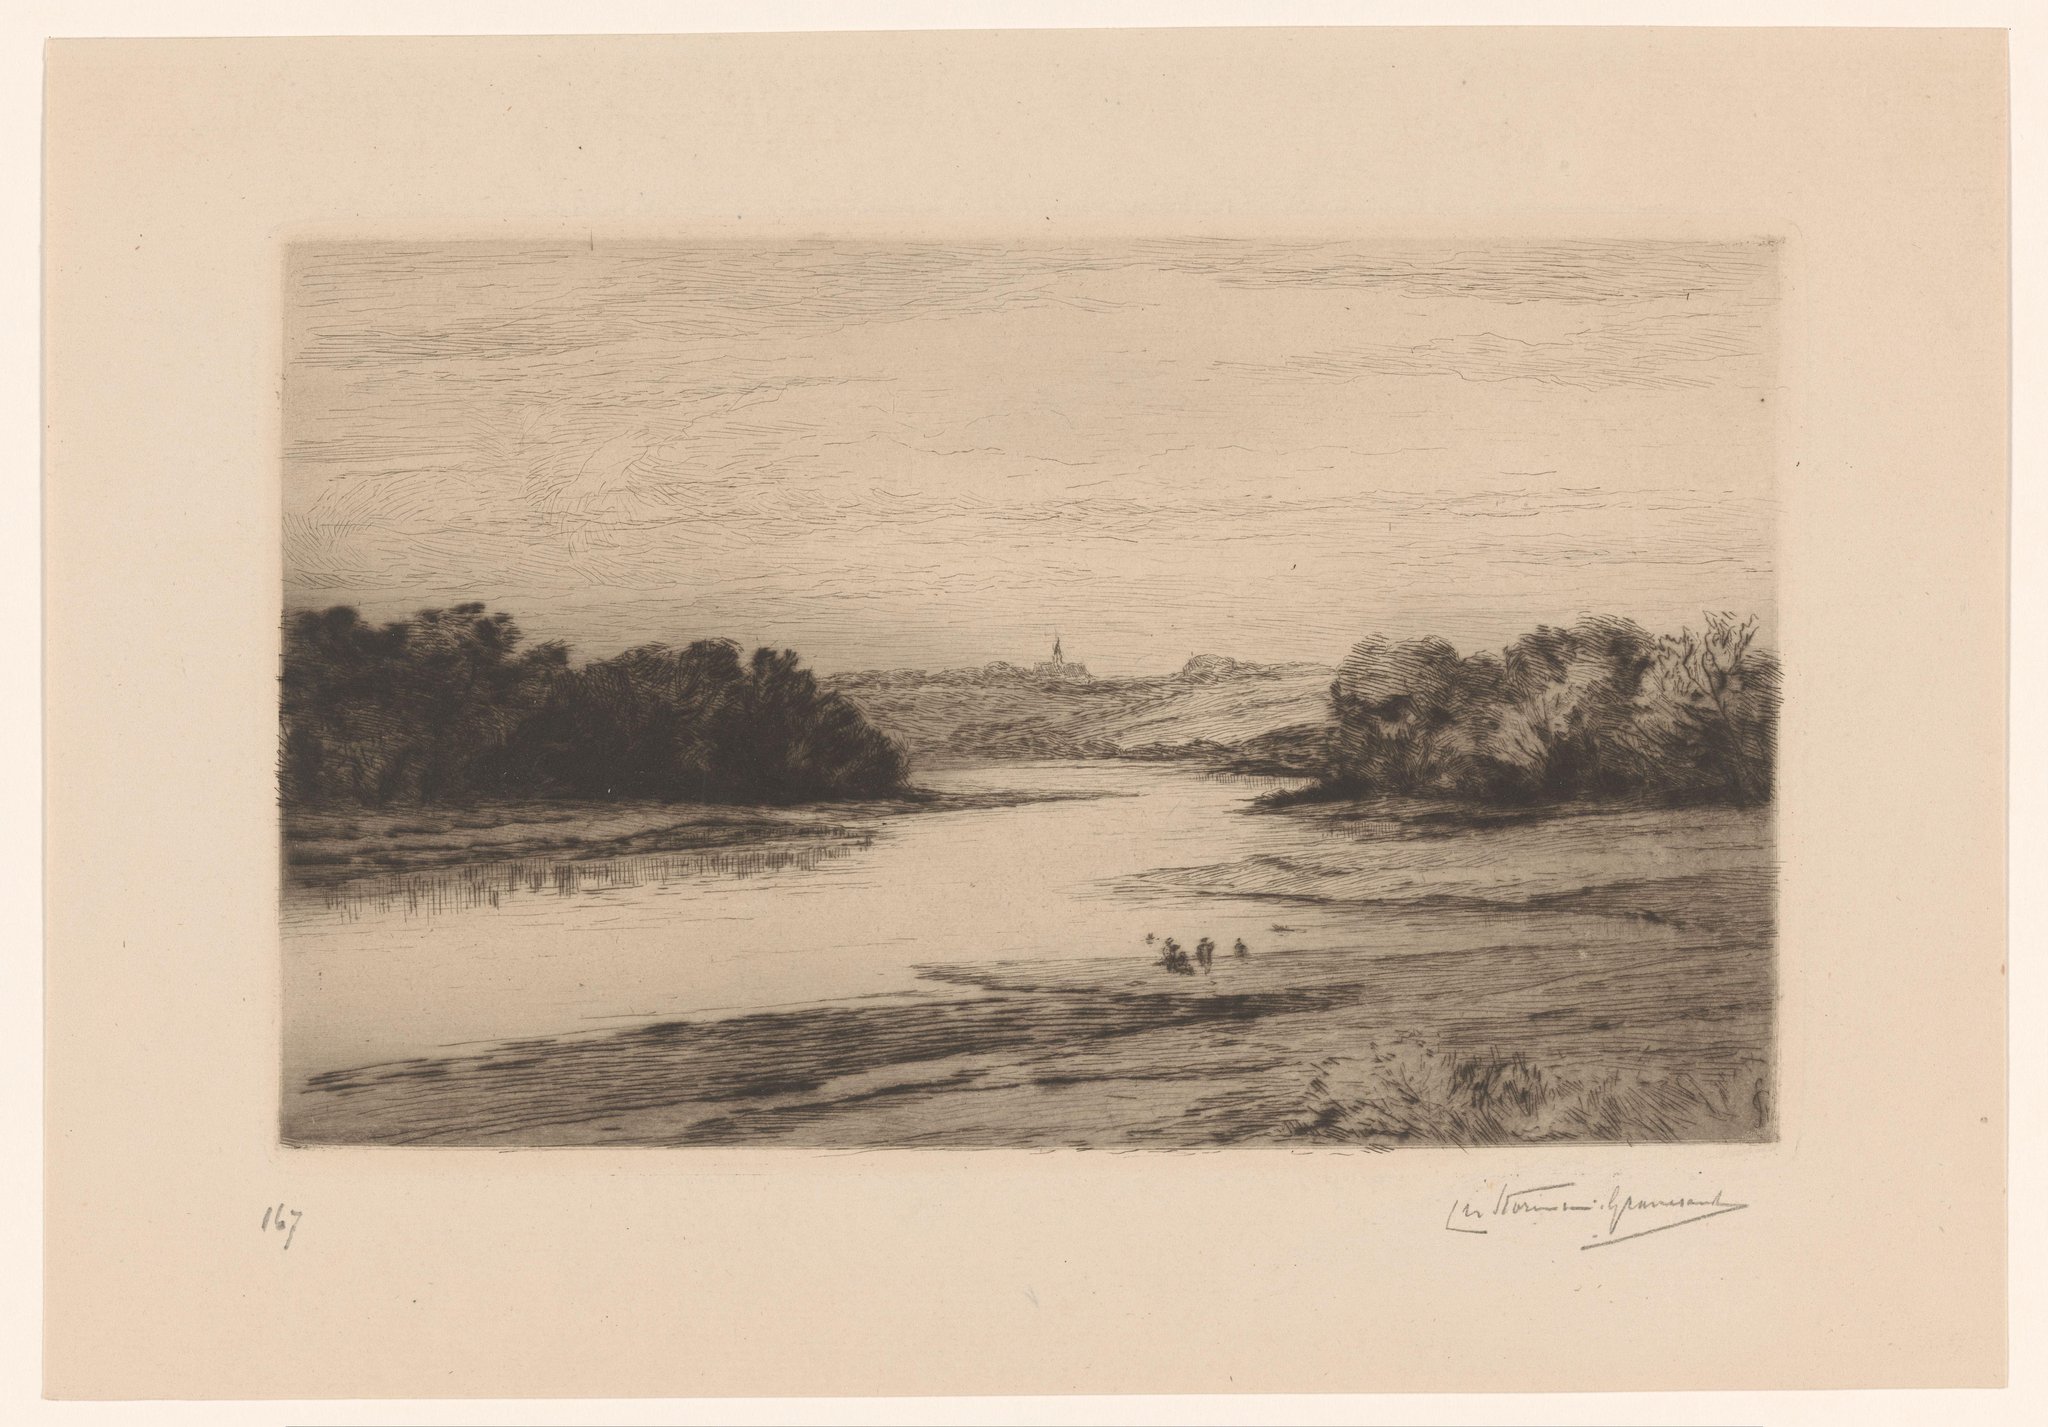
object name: print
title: Riviergezicht bij Auray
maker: carel nicolaas storm van s-gravesande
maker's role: draughtsman, print maker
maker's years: 1841-1924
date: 1880-1884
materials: paper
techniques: drypoint, intaglio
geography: netherlands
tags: river (+ landscape with figures, staffage)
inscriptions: collector's mark: Lugt 2228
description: Aan de horizon is op een heuvel een kerktoren te zien.